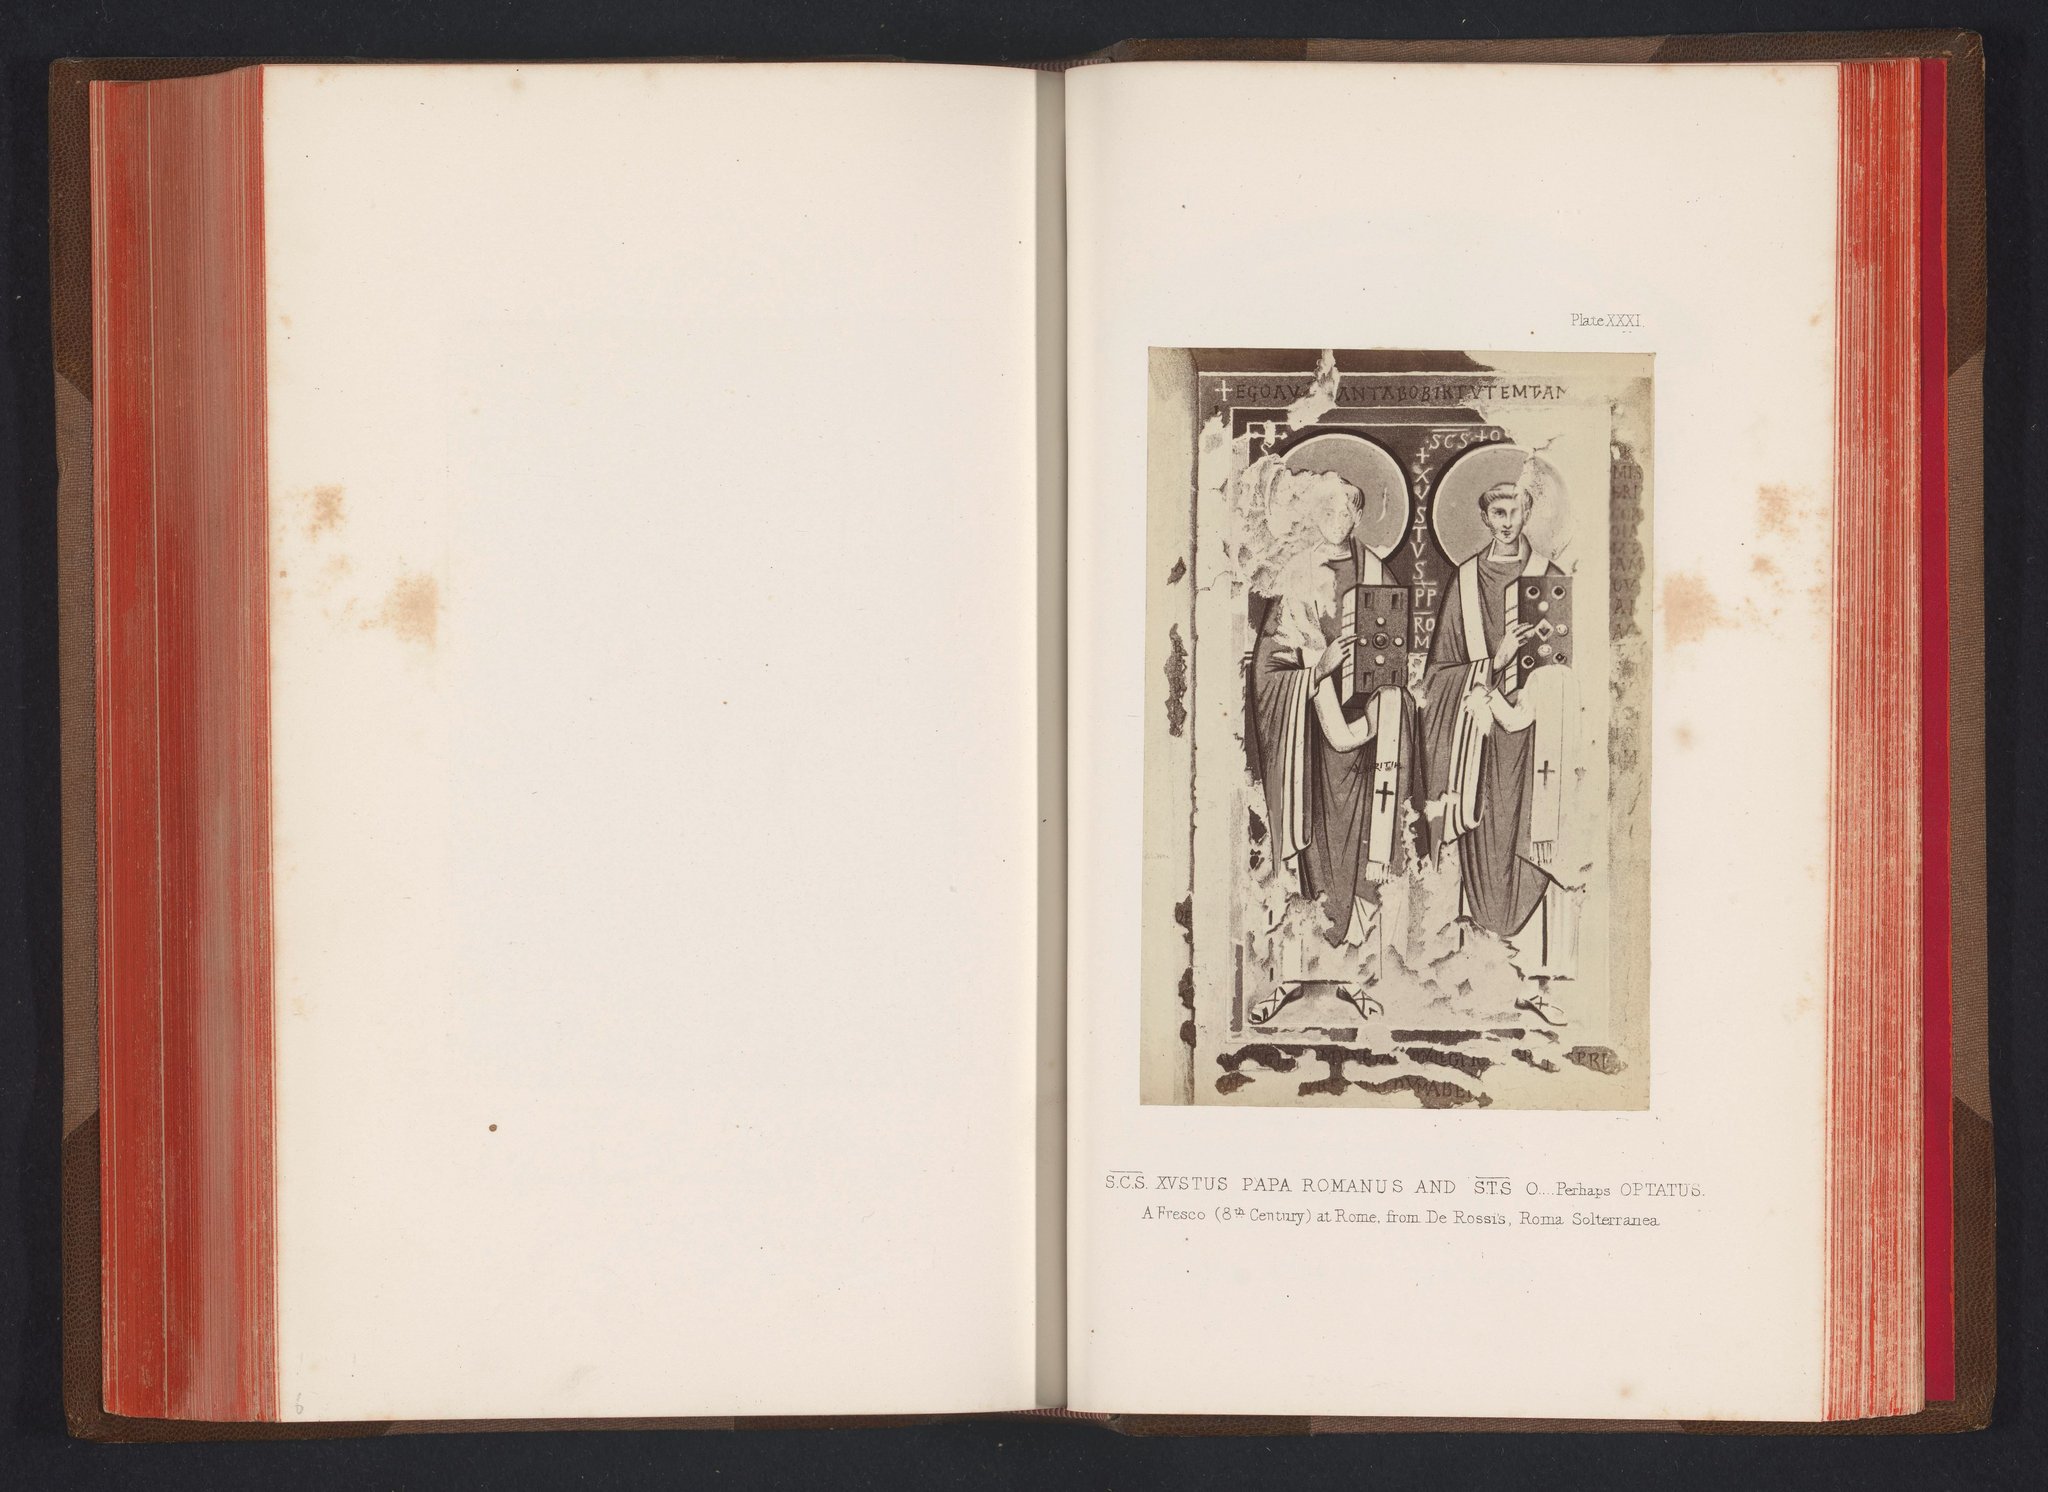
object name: reproduction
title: S.C.S. Xustus papa Romanus and S.T.S. O..Perhaps Optatus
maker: Anonymous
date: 1858-1868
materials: photographic support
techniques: albumen print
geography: rome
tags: saints, pope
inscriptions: number: ‘Plate XXXI’, inscription: ‘A Fresco (8th Century) at Rome, from De Rossi's, Roma Solterranea.’